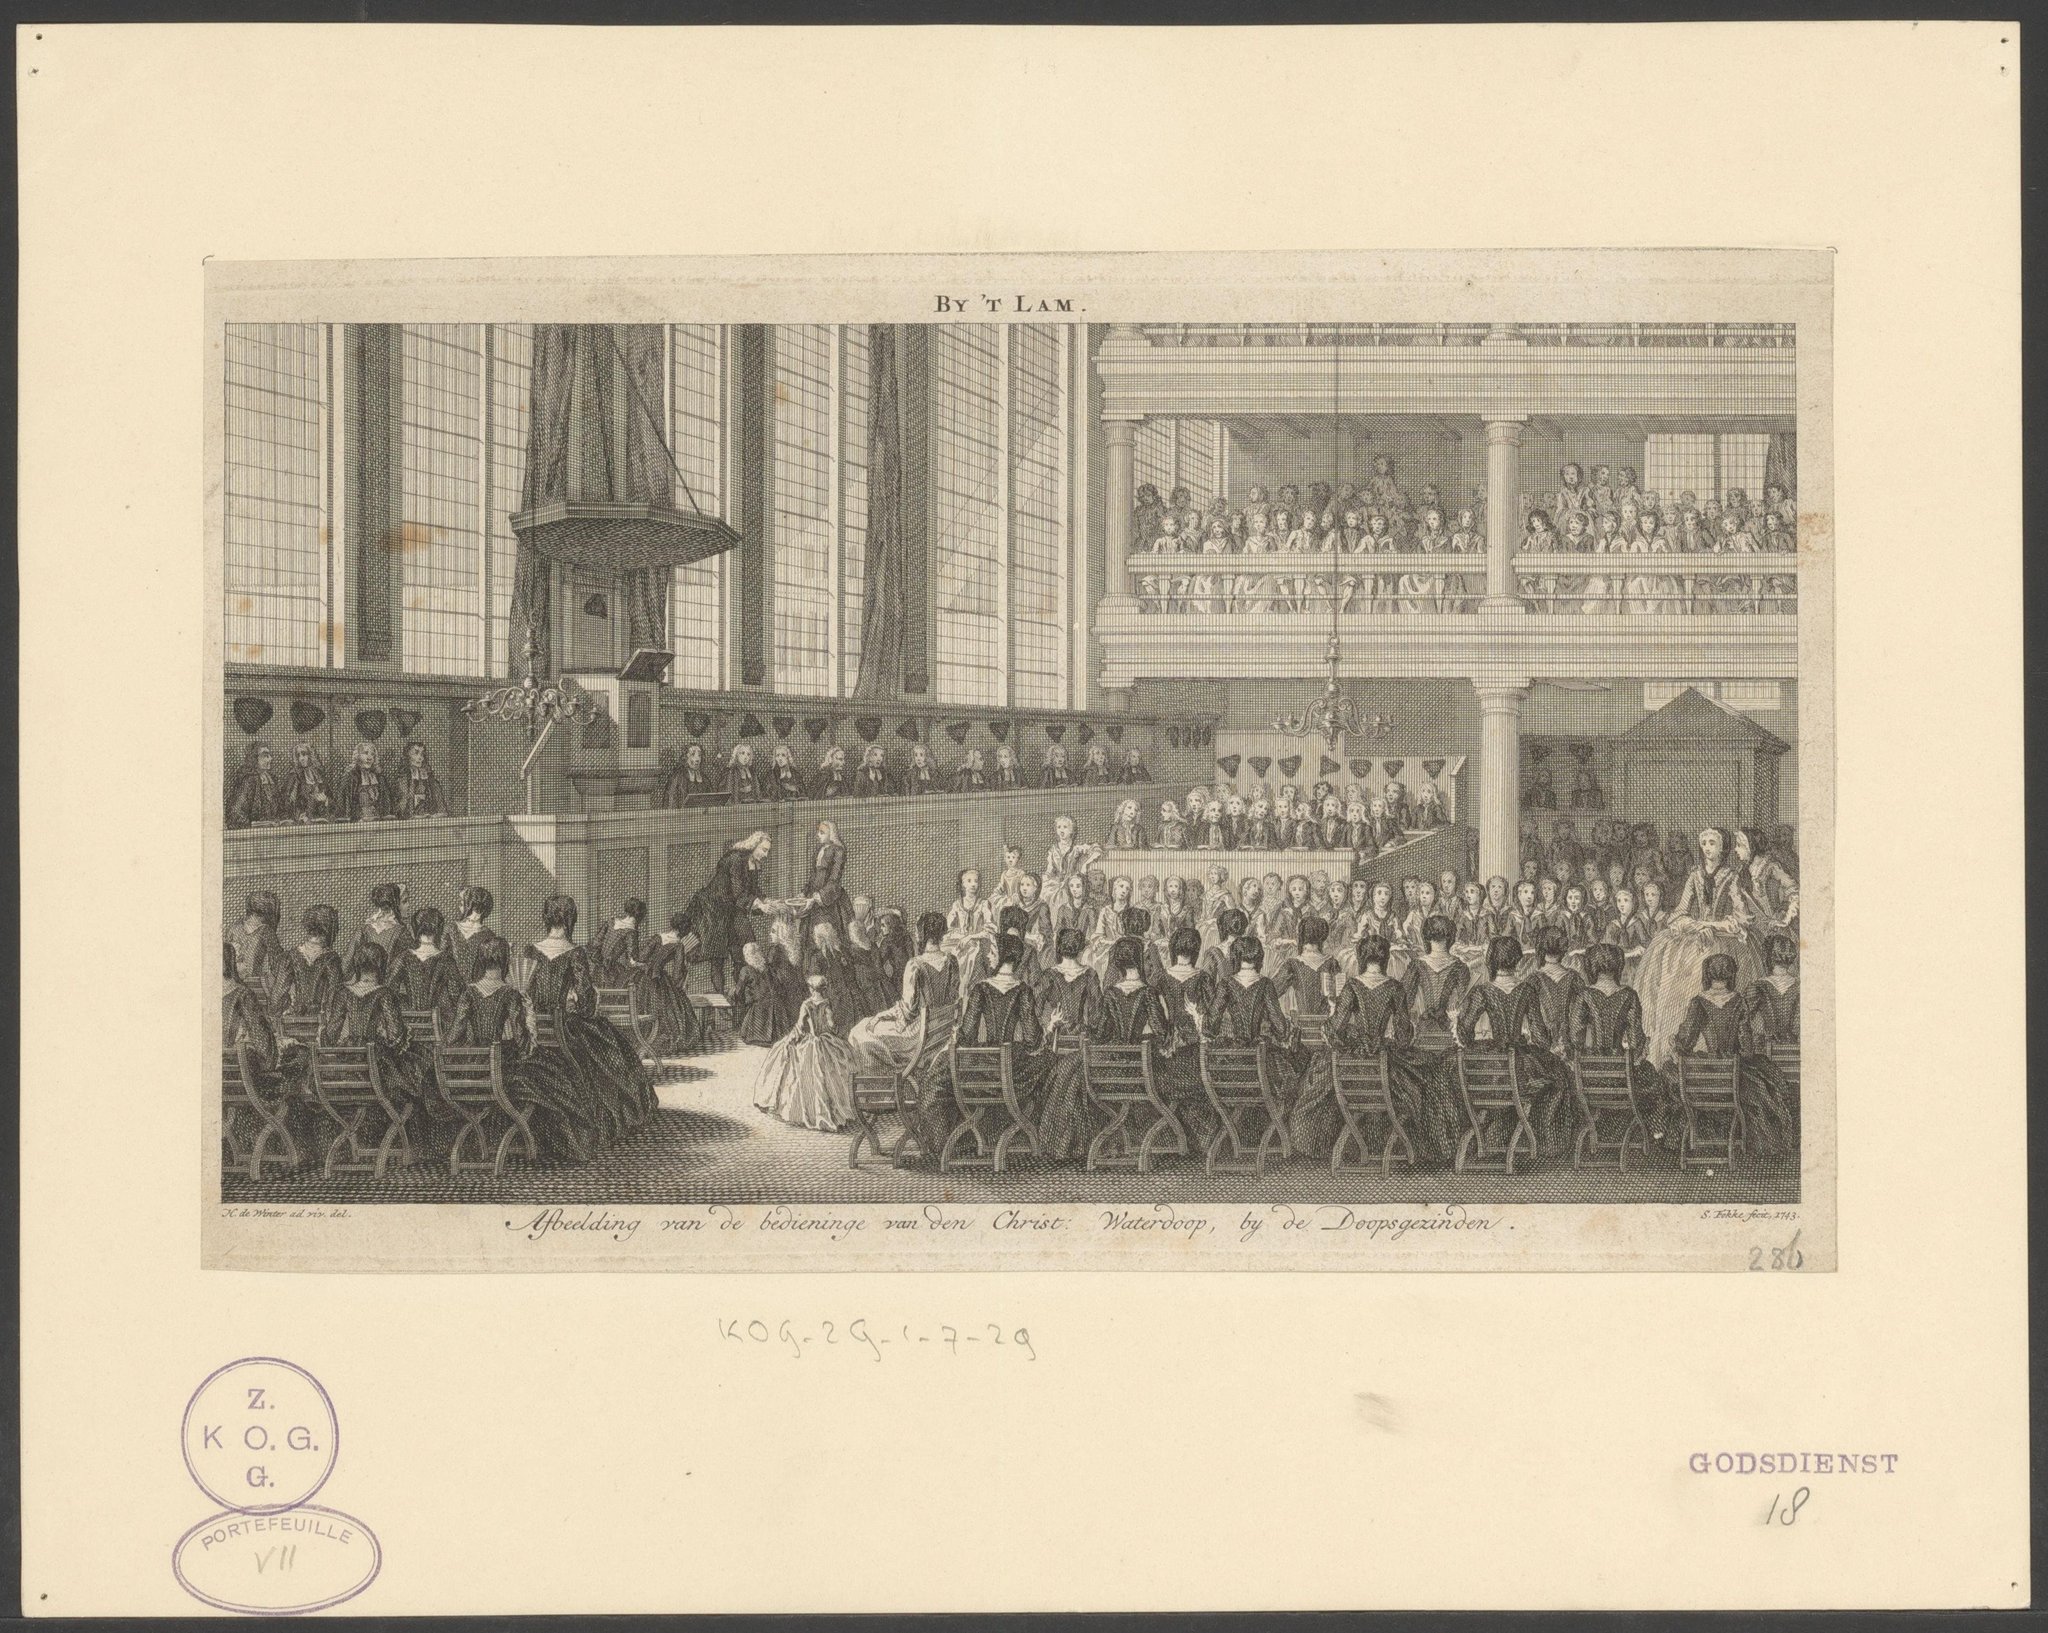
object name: print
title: Doop in de Doopsgezinde Kerk Bij 't Lam te Amsterdam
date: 1743-1750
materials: paper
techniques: engraving, etching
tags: protestant churches and denominations (mennonites), baptism, christening ceremony ~ the first of the seven sacraments, interior of church, amsterdam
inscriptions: stamp, stamp, collector's mark: Lugt 1641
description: Prent waarschijnlijk uit: Schijn, Hermannus. Geschiedenis dier christenen, welke in de Vereenigde Nederlanden onder de protestanten mennoniten genaamd worden (...). Amsterdam: Kornelis de Wit, 1743. Of uit: Maatschoen, G. Levensbeschryving van eenige voornaame mannen, in hun leven leeraaren, by de Doopsgezinden (...). Amsterdam: Kornelis de Wit, 1750.